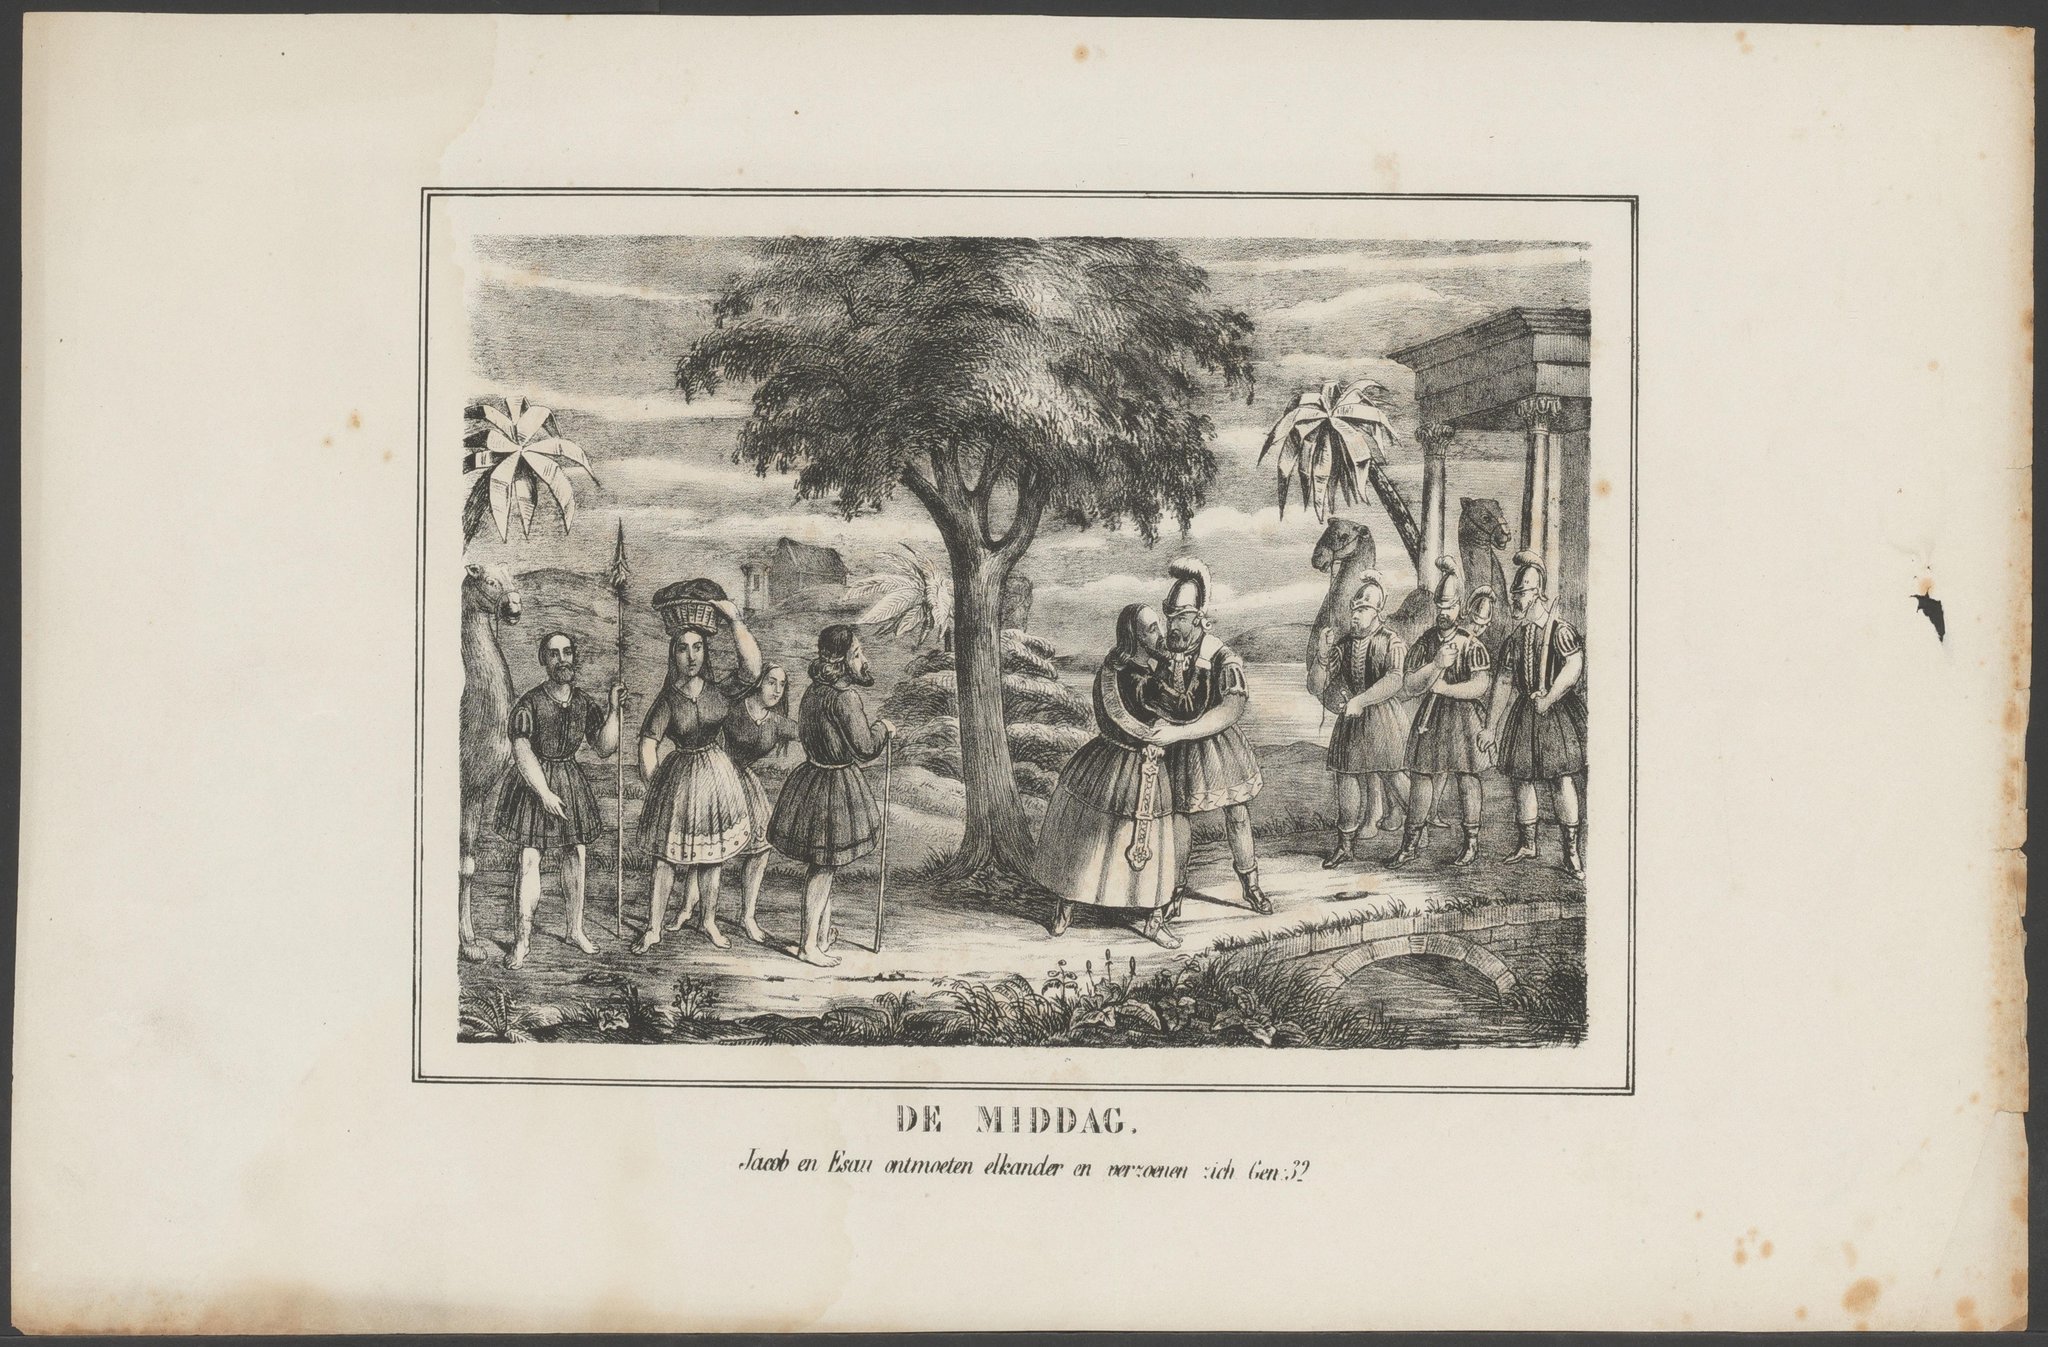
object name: print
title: Verzoening van Jakob en Esau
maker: Anonymous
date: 1795-1899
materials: paper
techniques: lithograph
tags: jacob and esau are reconciled (genesis 33)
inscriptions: collector's mark: Lugt 1641, collector's mark: Lugt 2233, stamp:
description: Onderwerpsrubrieken binnen de Atlas Zeden en Gewoonten: Godsdienst, Figuren van Christus en heiligen.